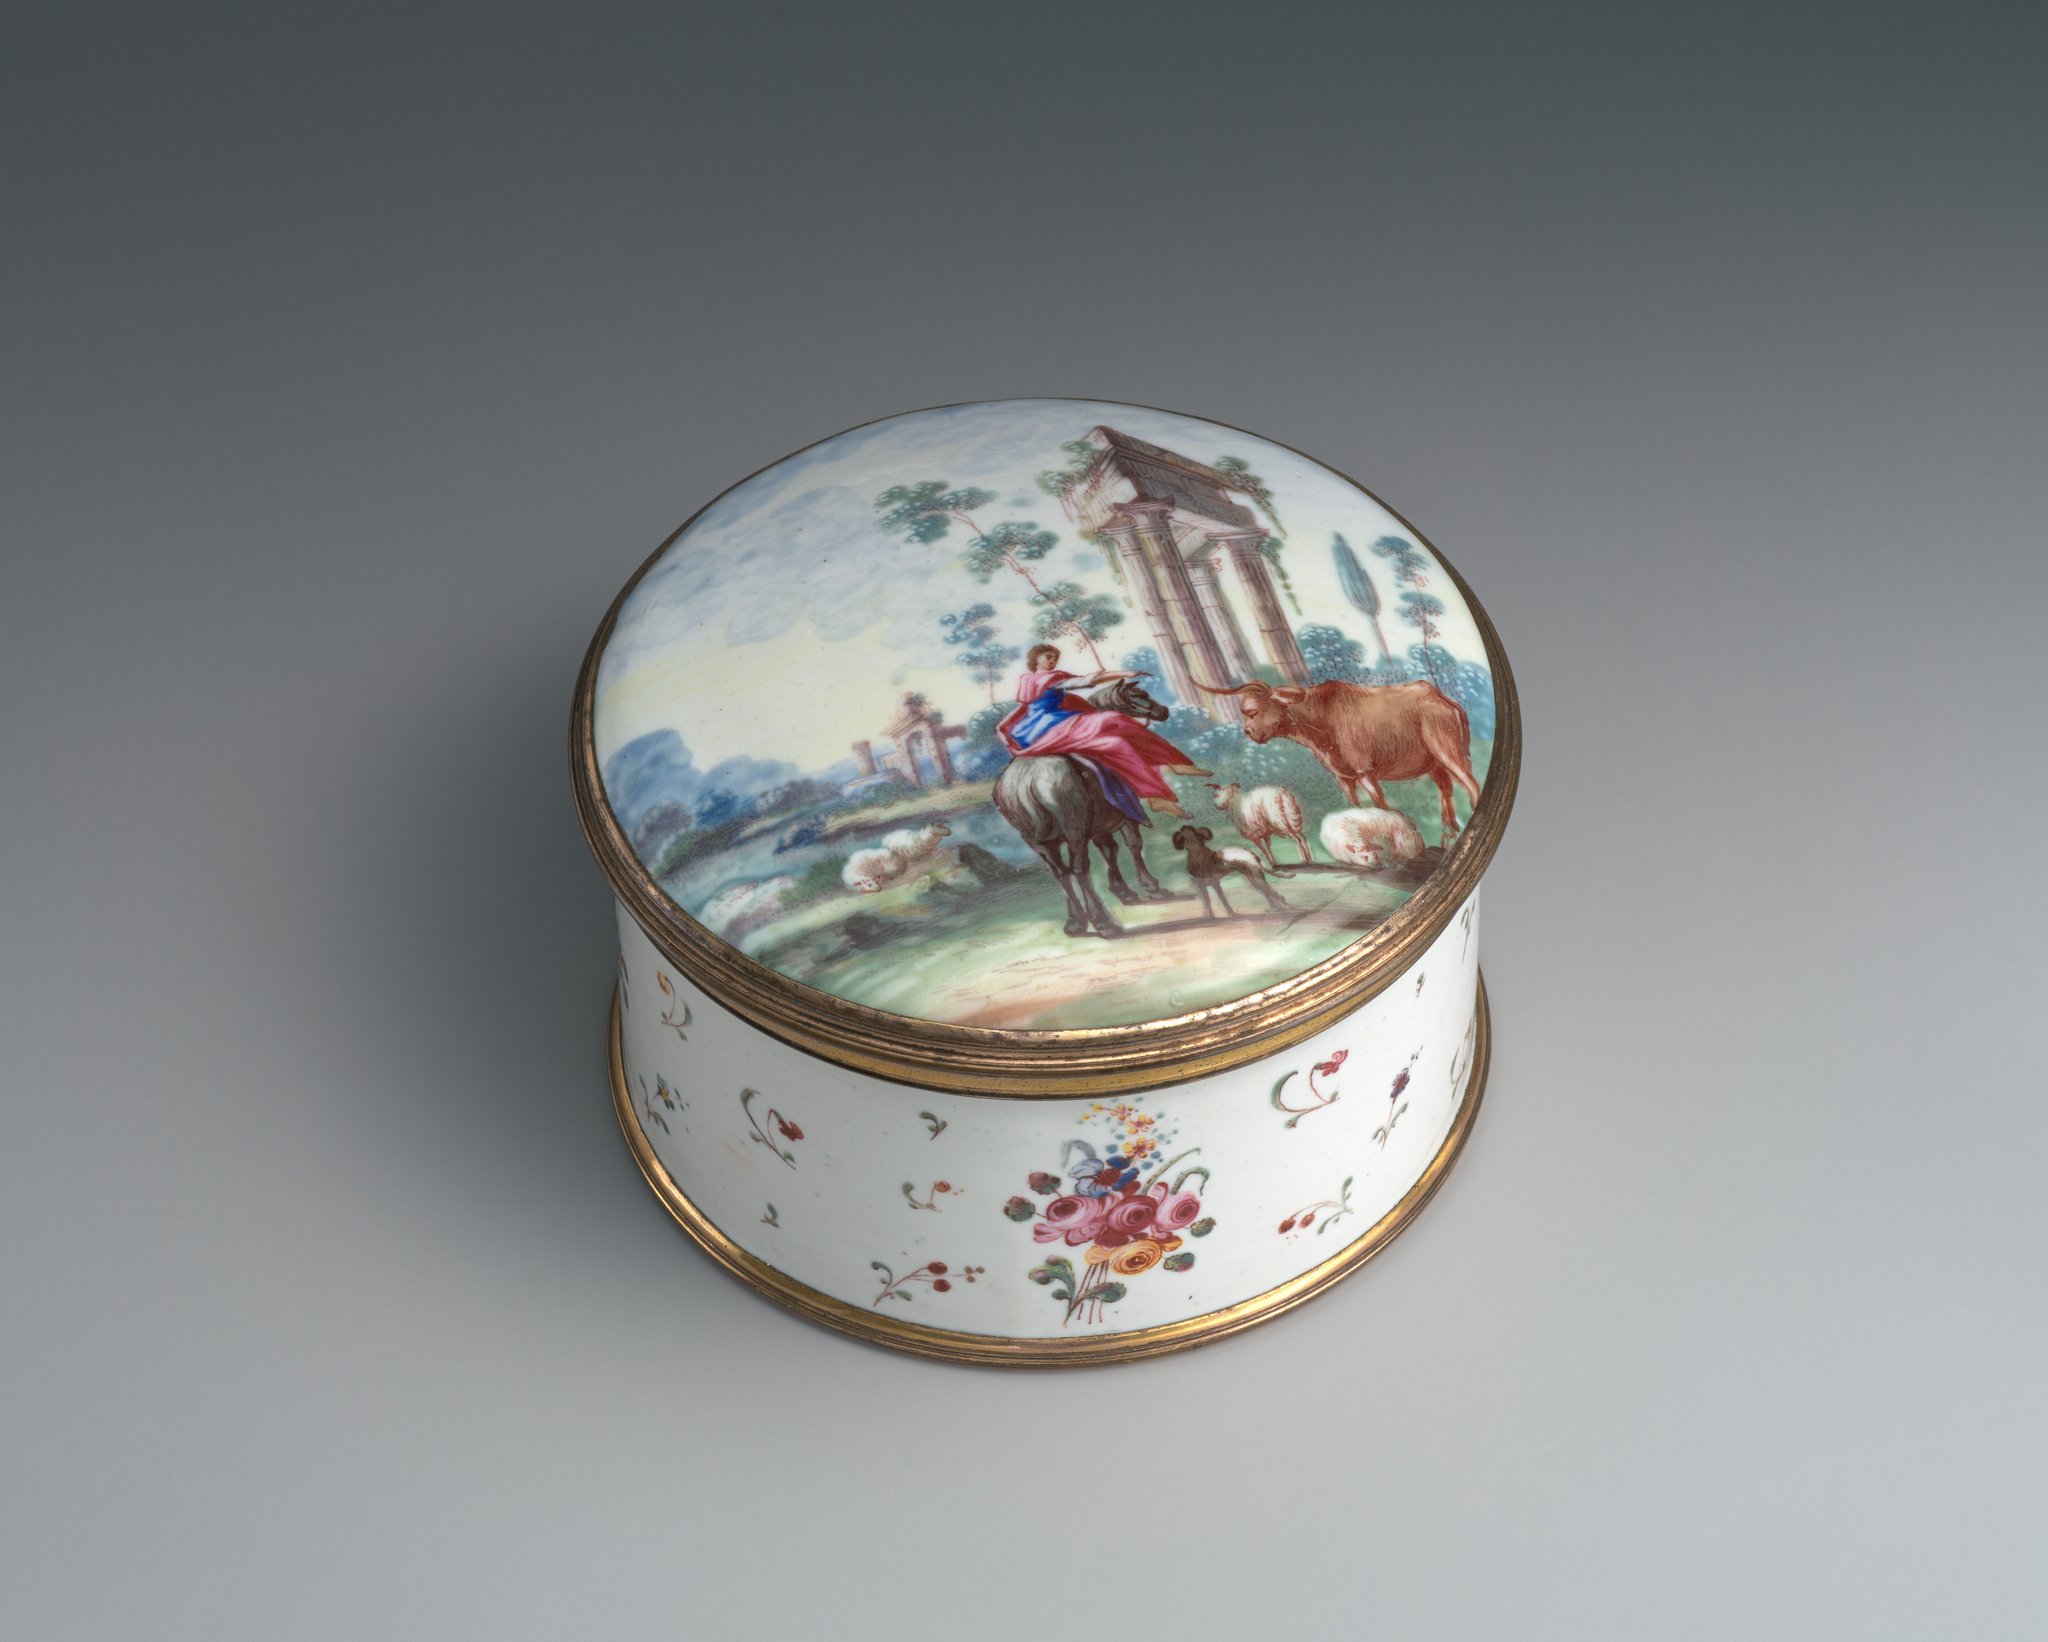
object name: box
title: Toilet box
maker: dancker danckerts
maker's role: engraver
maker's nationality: dutch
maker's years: 1634-1666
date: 1750-1760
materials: copper, enamel